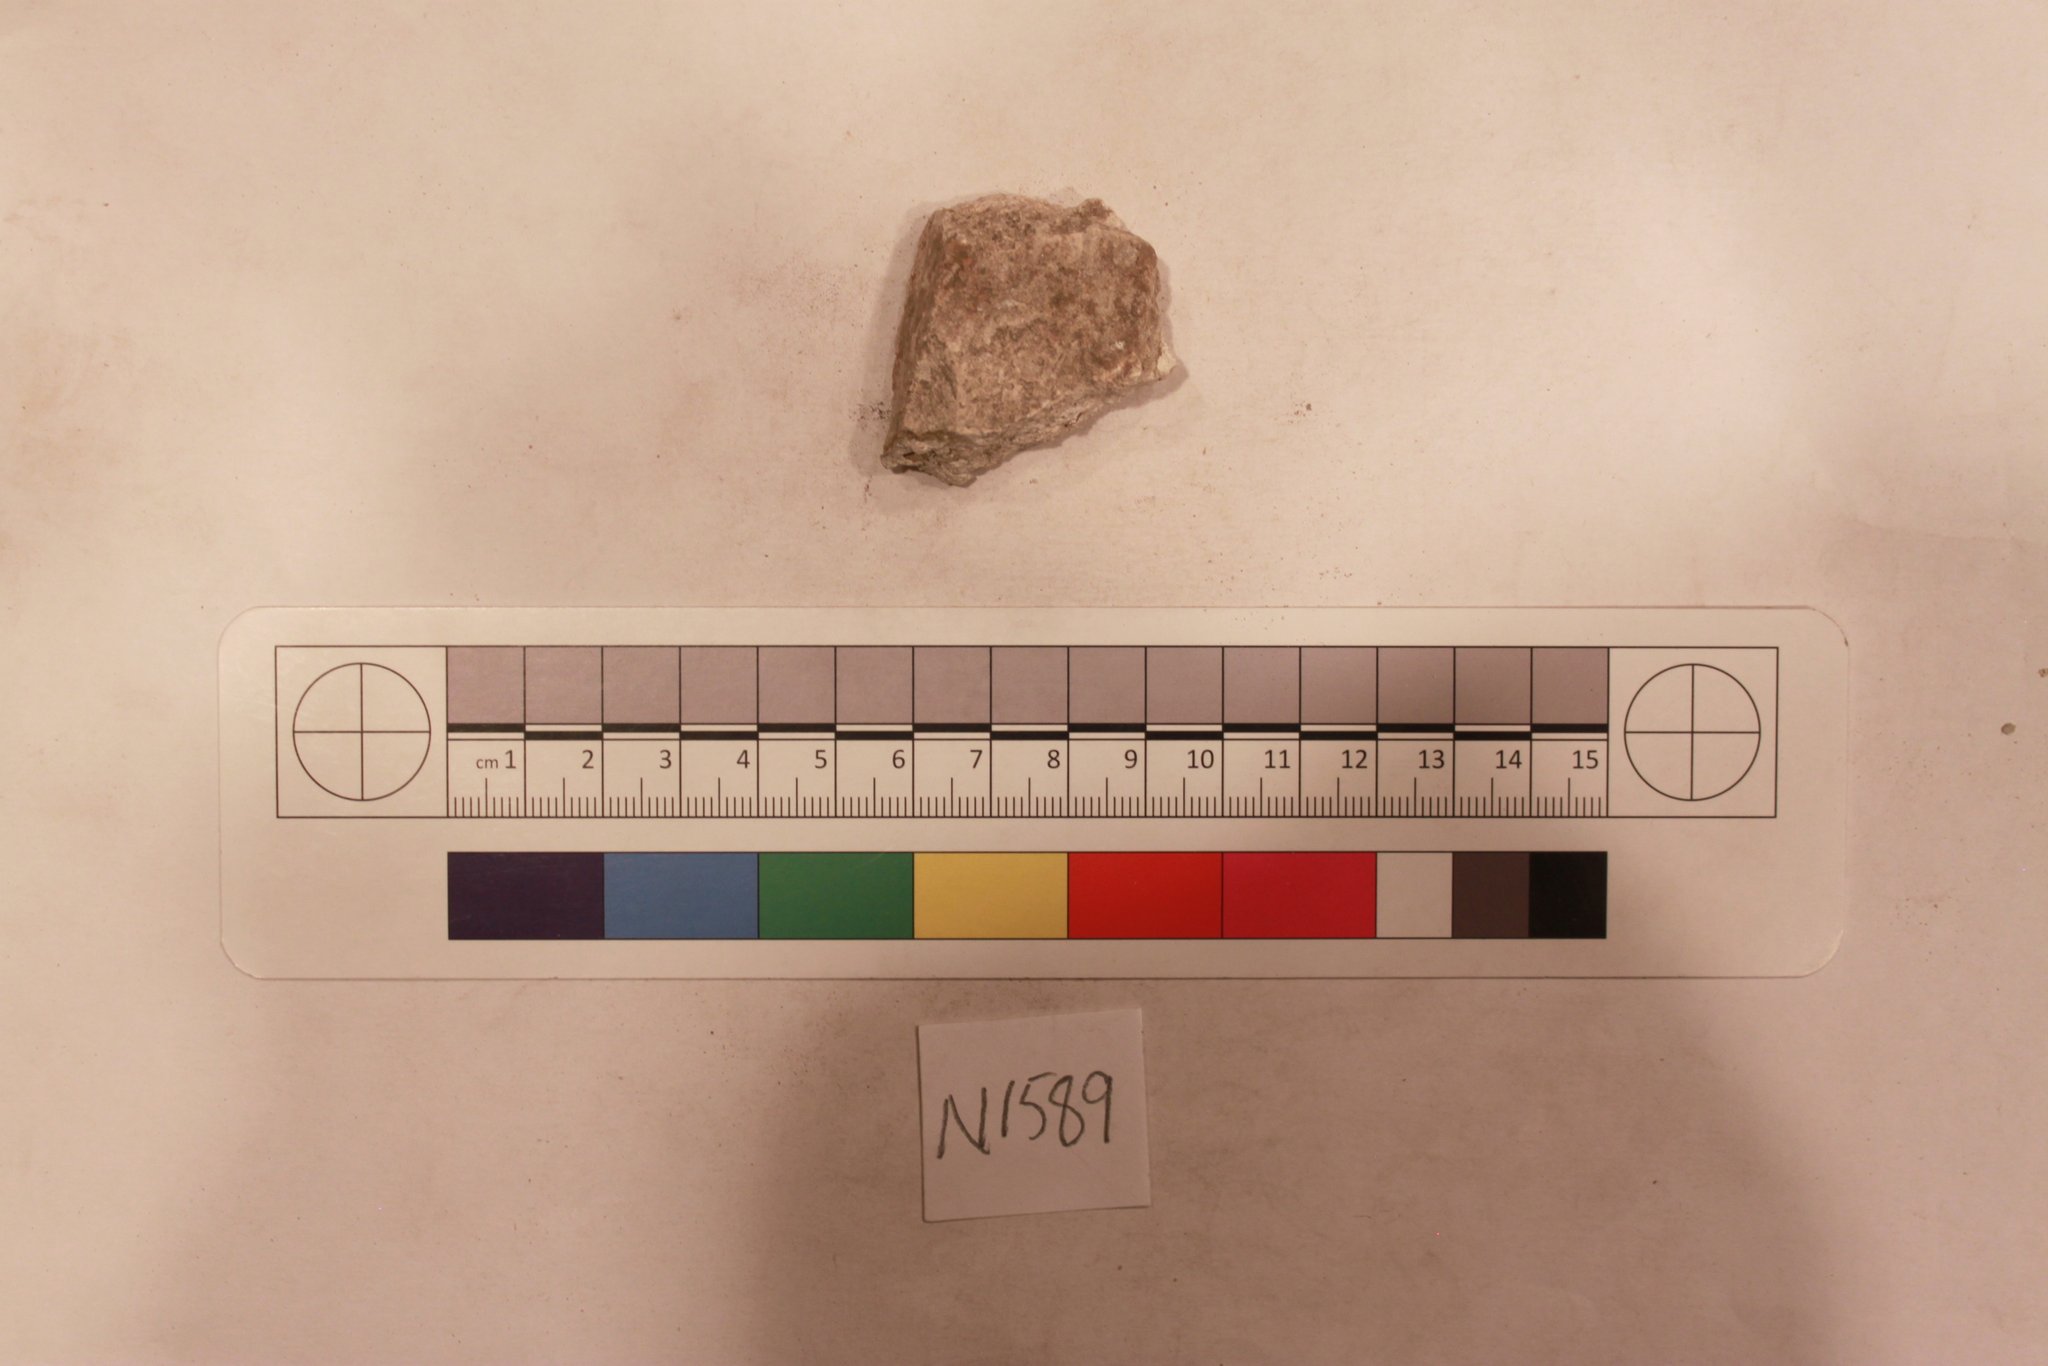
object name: fragment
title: Stucco Fragment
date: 701-1200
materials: plaster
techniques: carving, painting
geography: iran